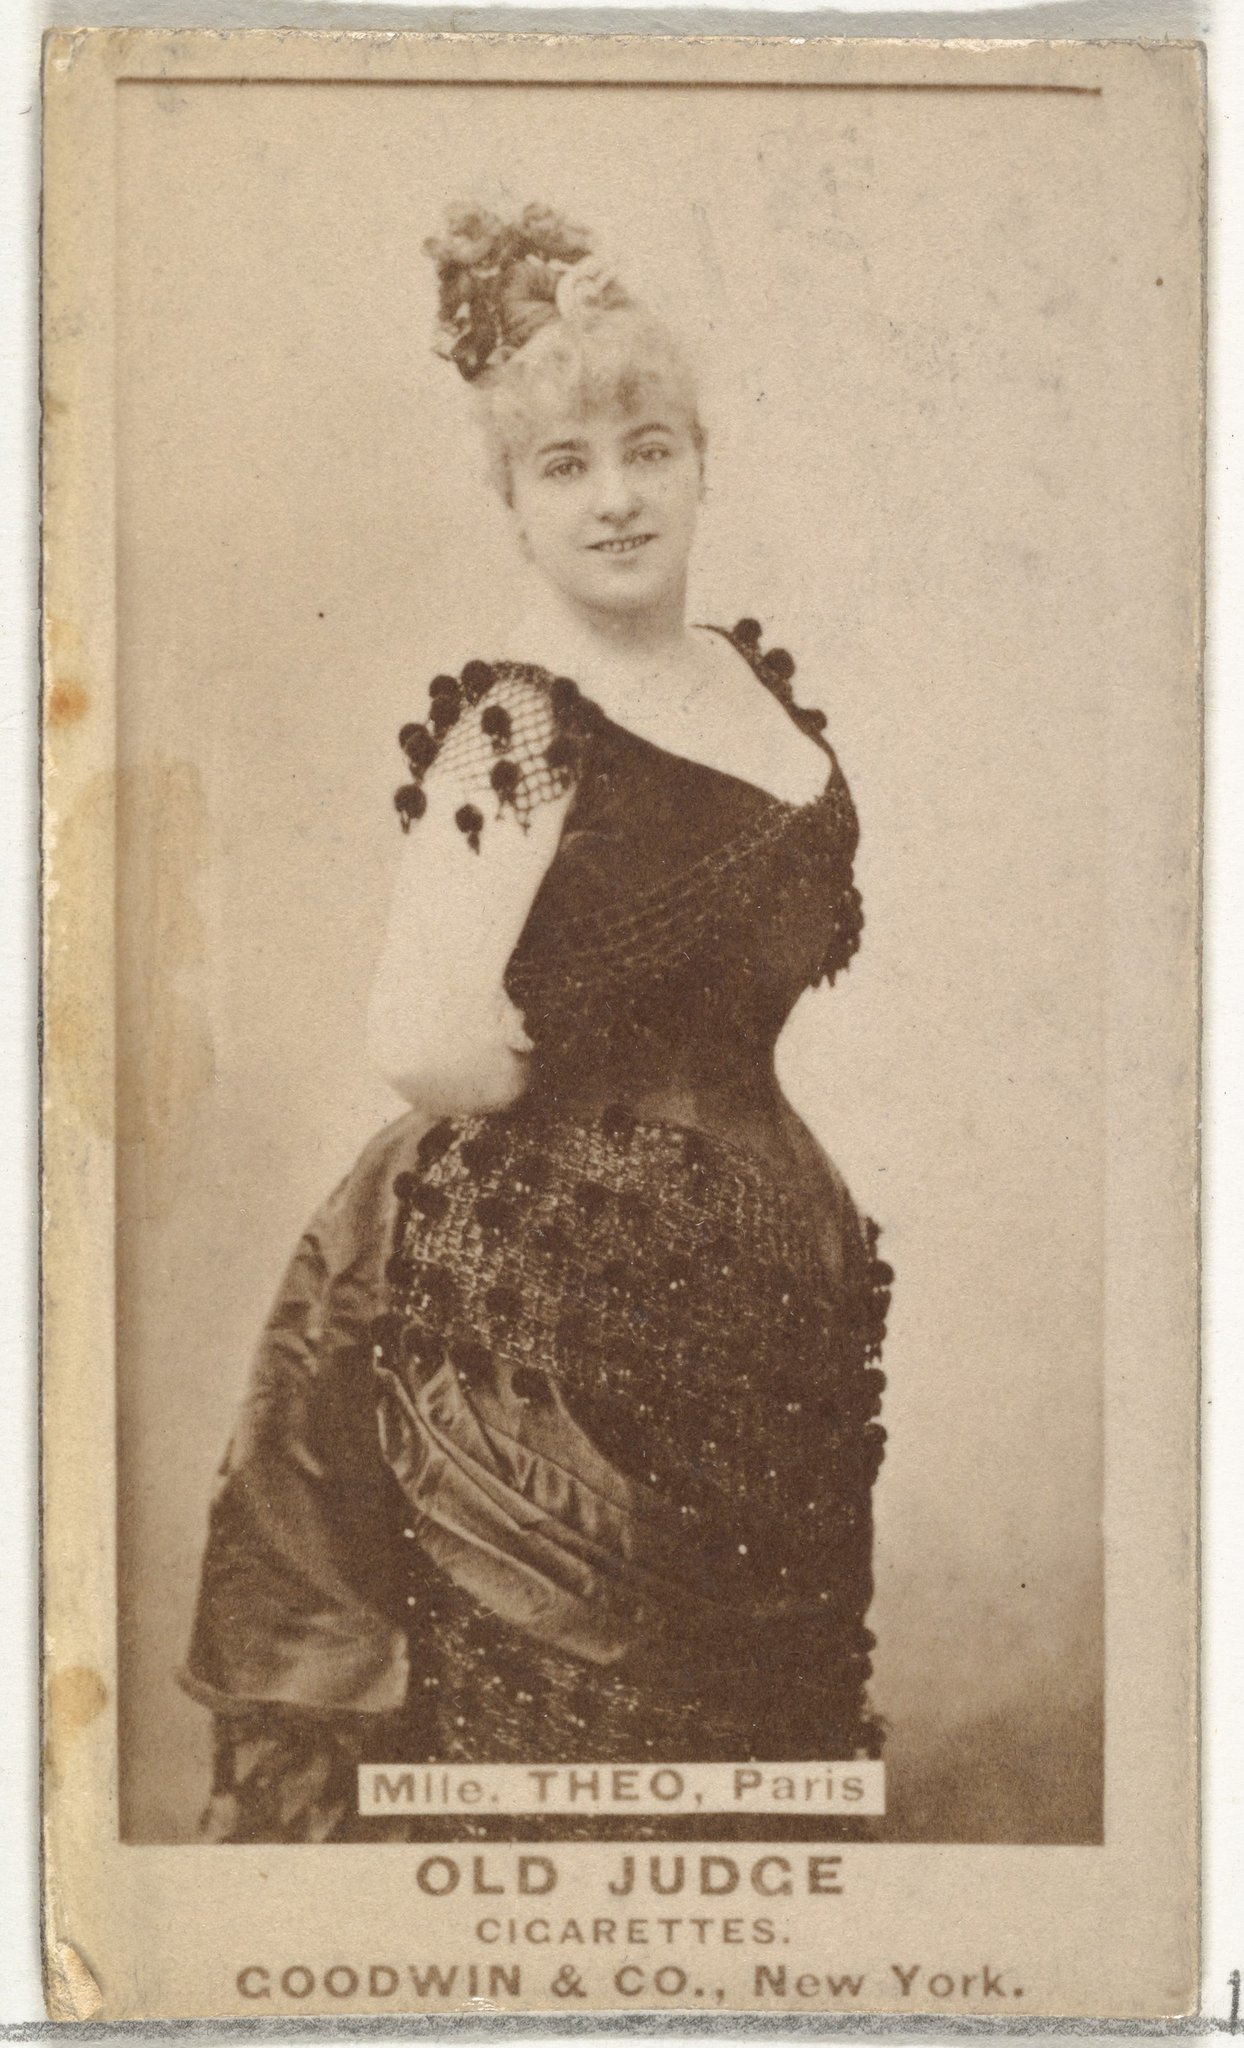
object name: photograph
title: Mlle. Theo, Paris, from the Actors and Actresses series (N171) for Old Judge Cigarettes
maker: goodwin & company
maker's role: publisher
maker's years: 1850-1950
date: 1886-1890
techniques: albumen silver print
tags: portraits,women,actresses